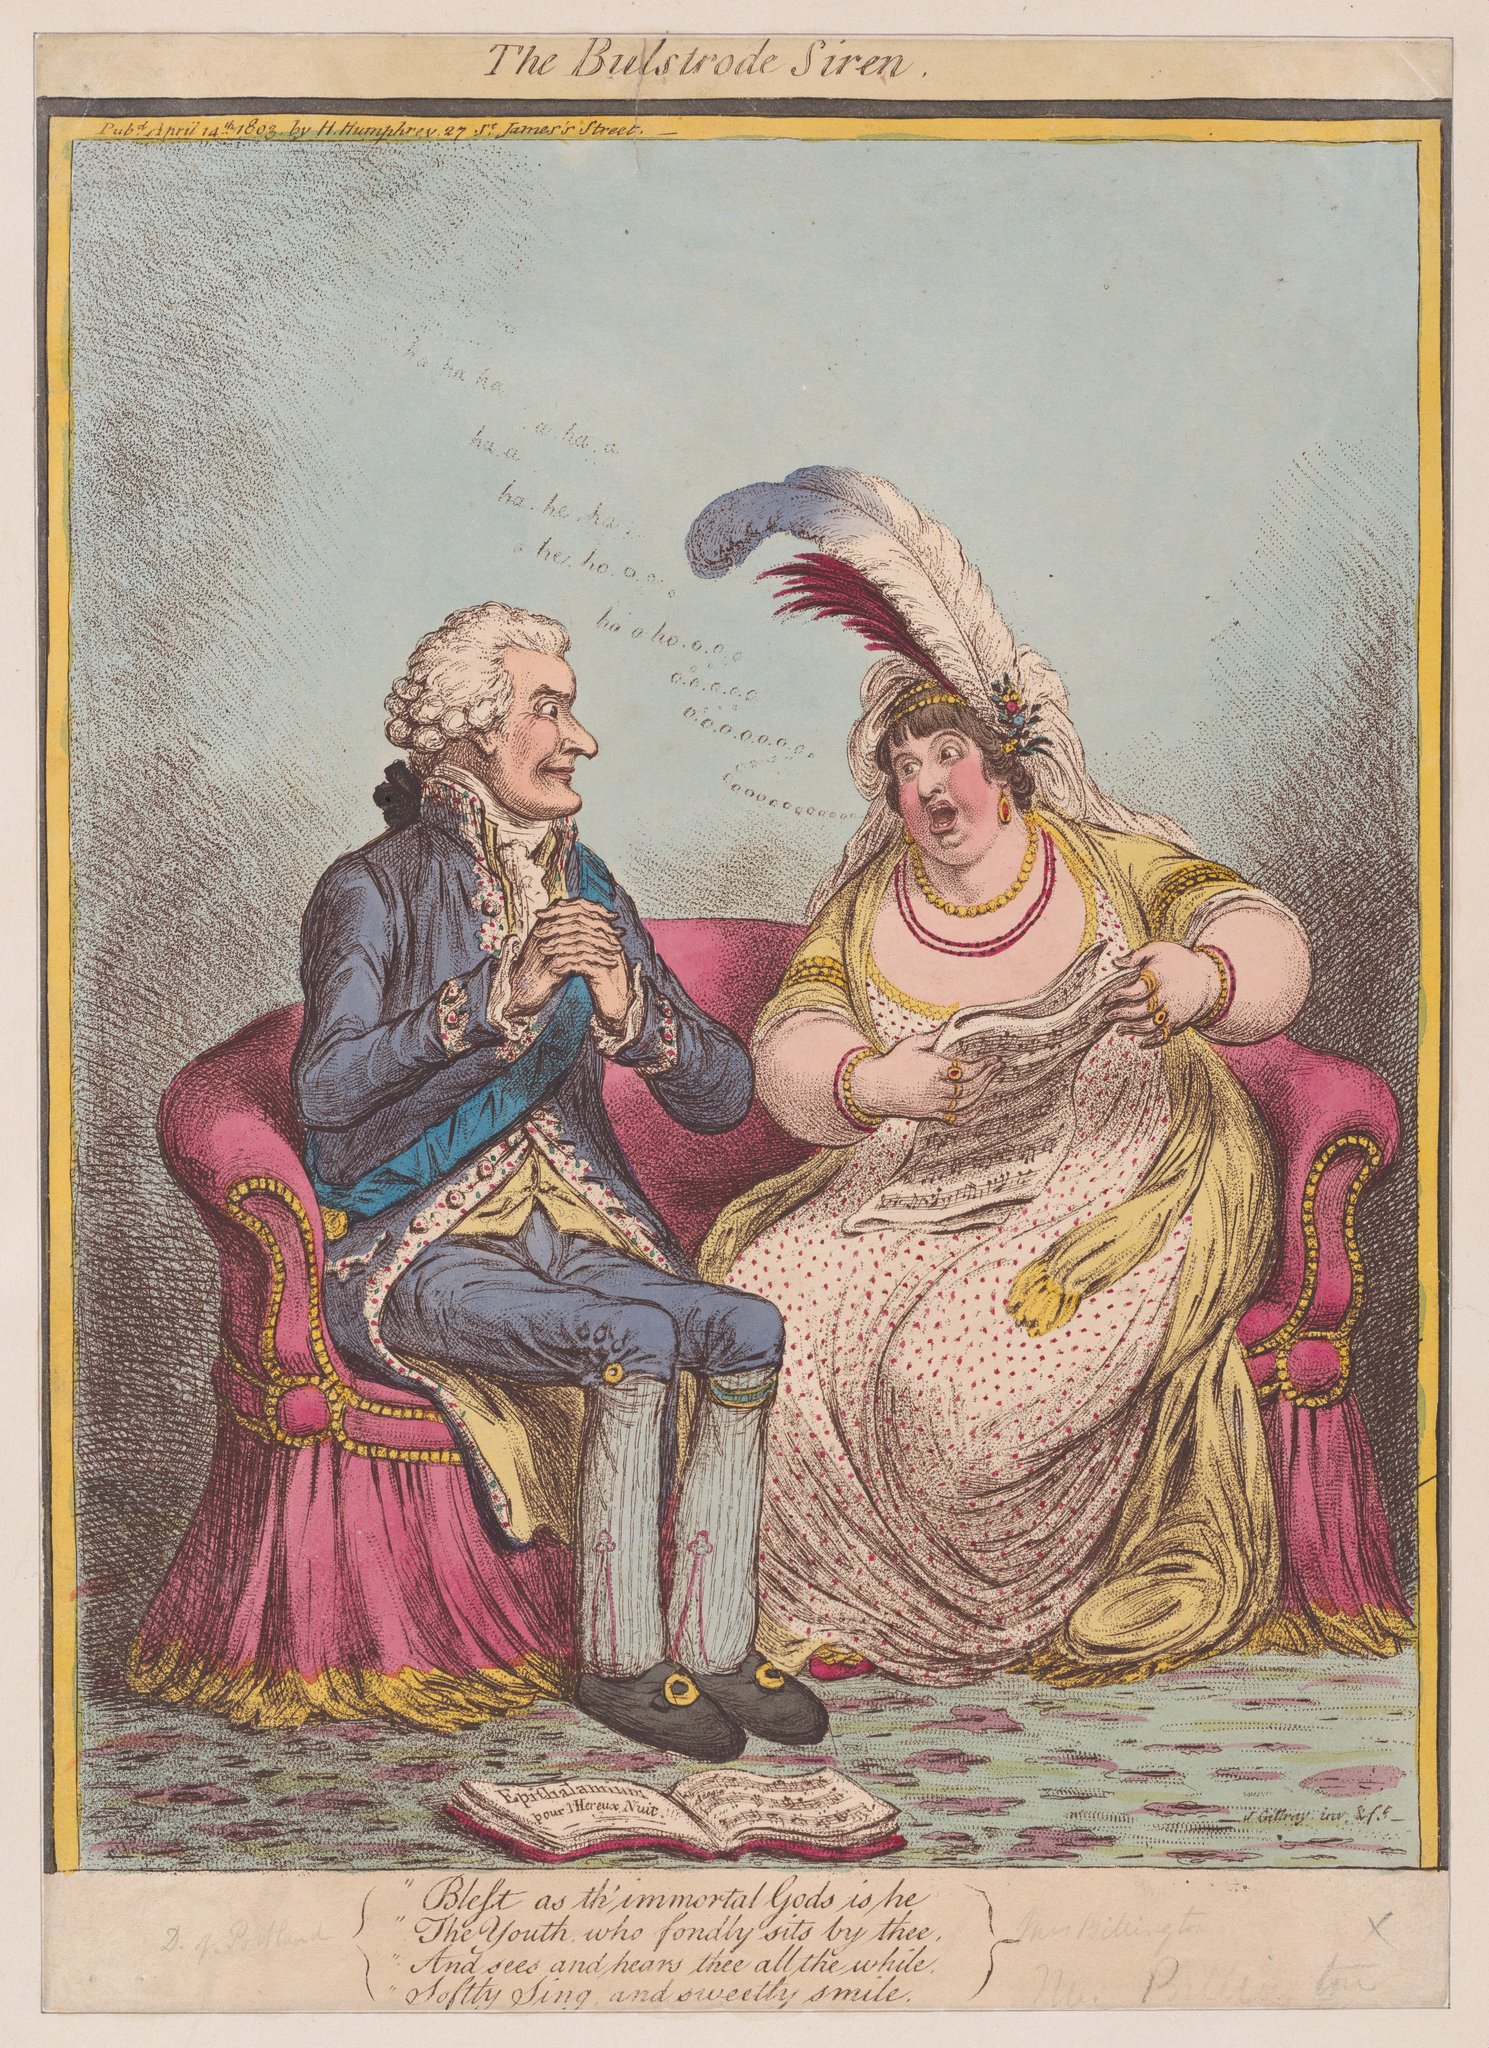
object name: print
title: The Bulstrode Siren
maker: james gillray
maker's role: artist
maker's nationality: british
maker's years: 1756-1815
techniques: etching, stippling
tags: men,women,singers,caricature